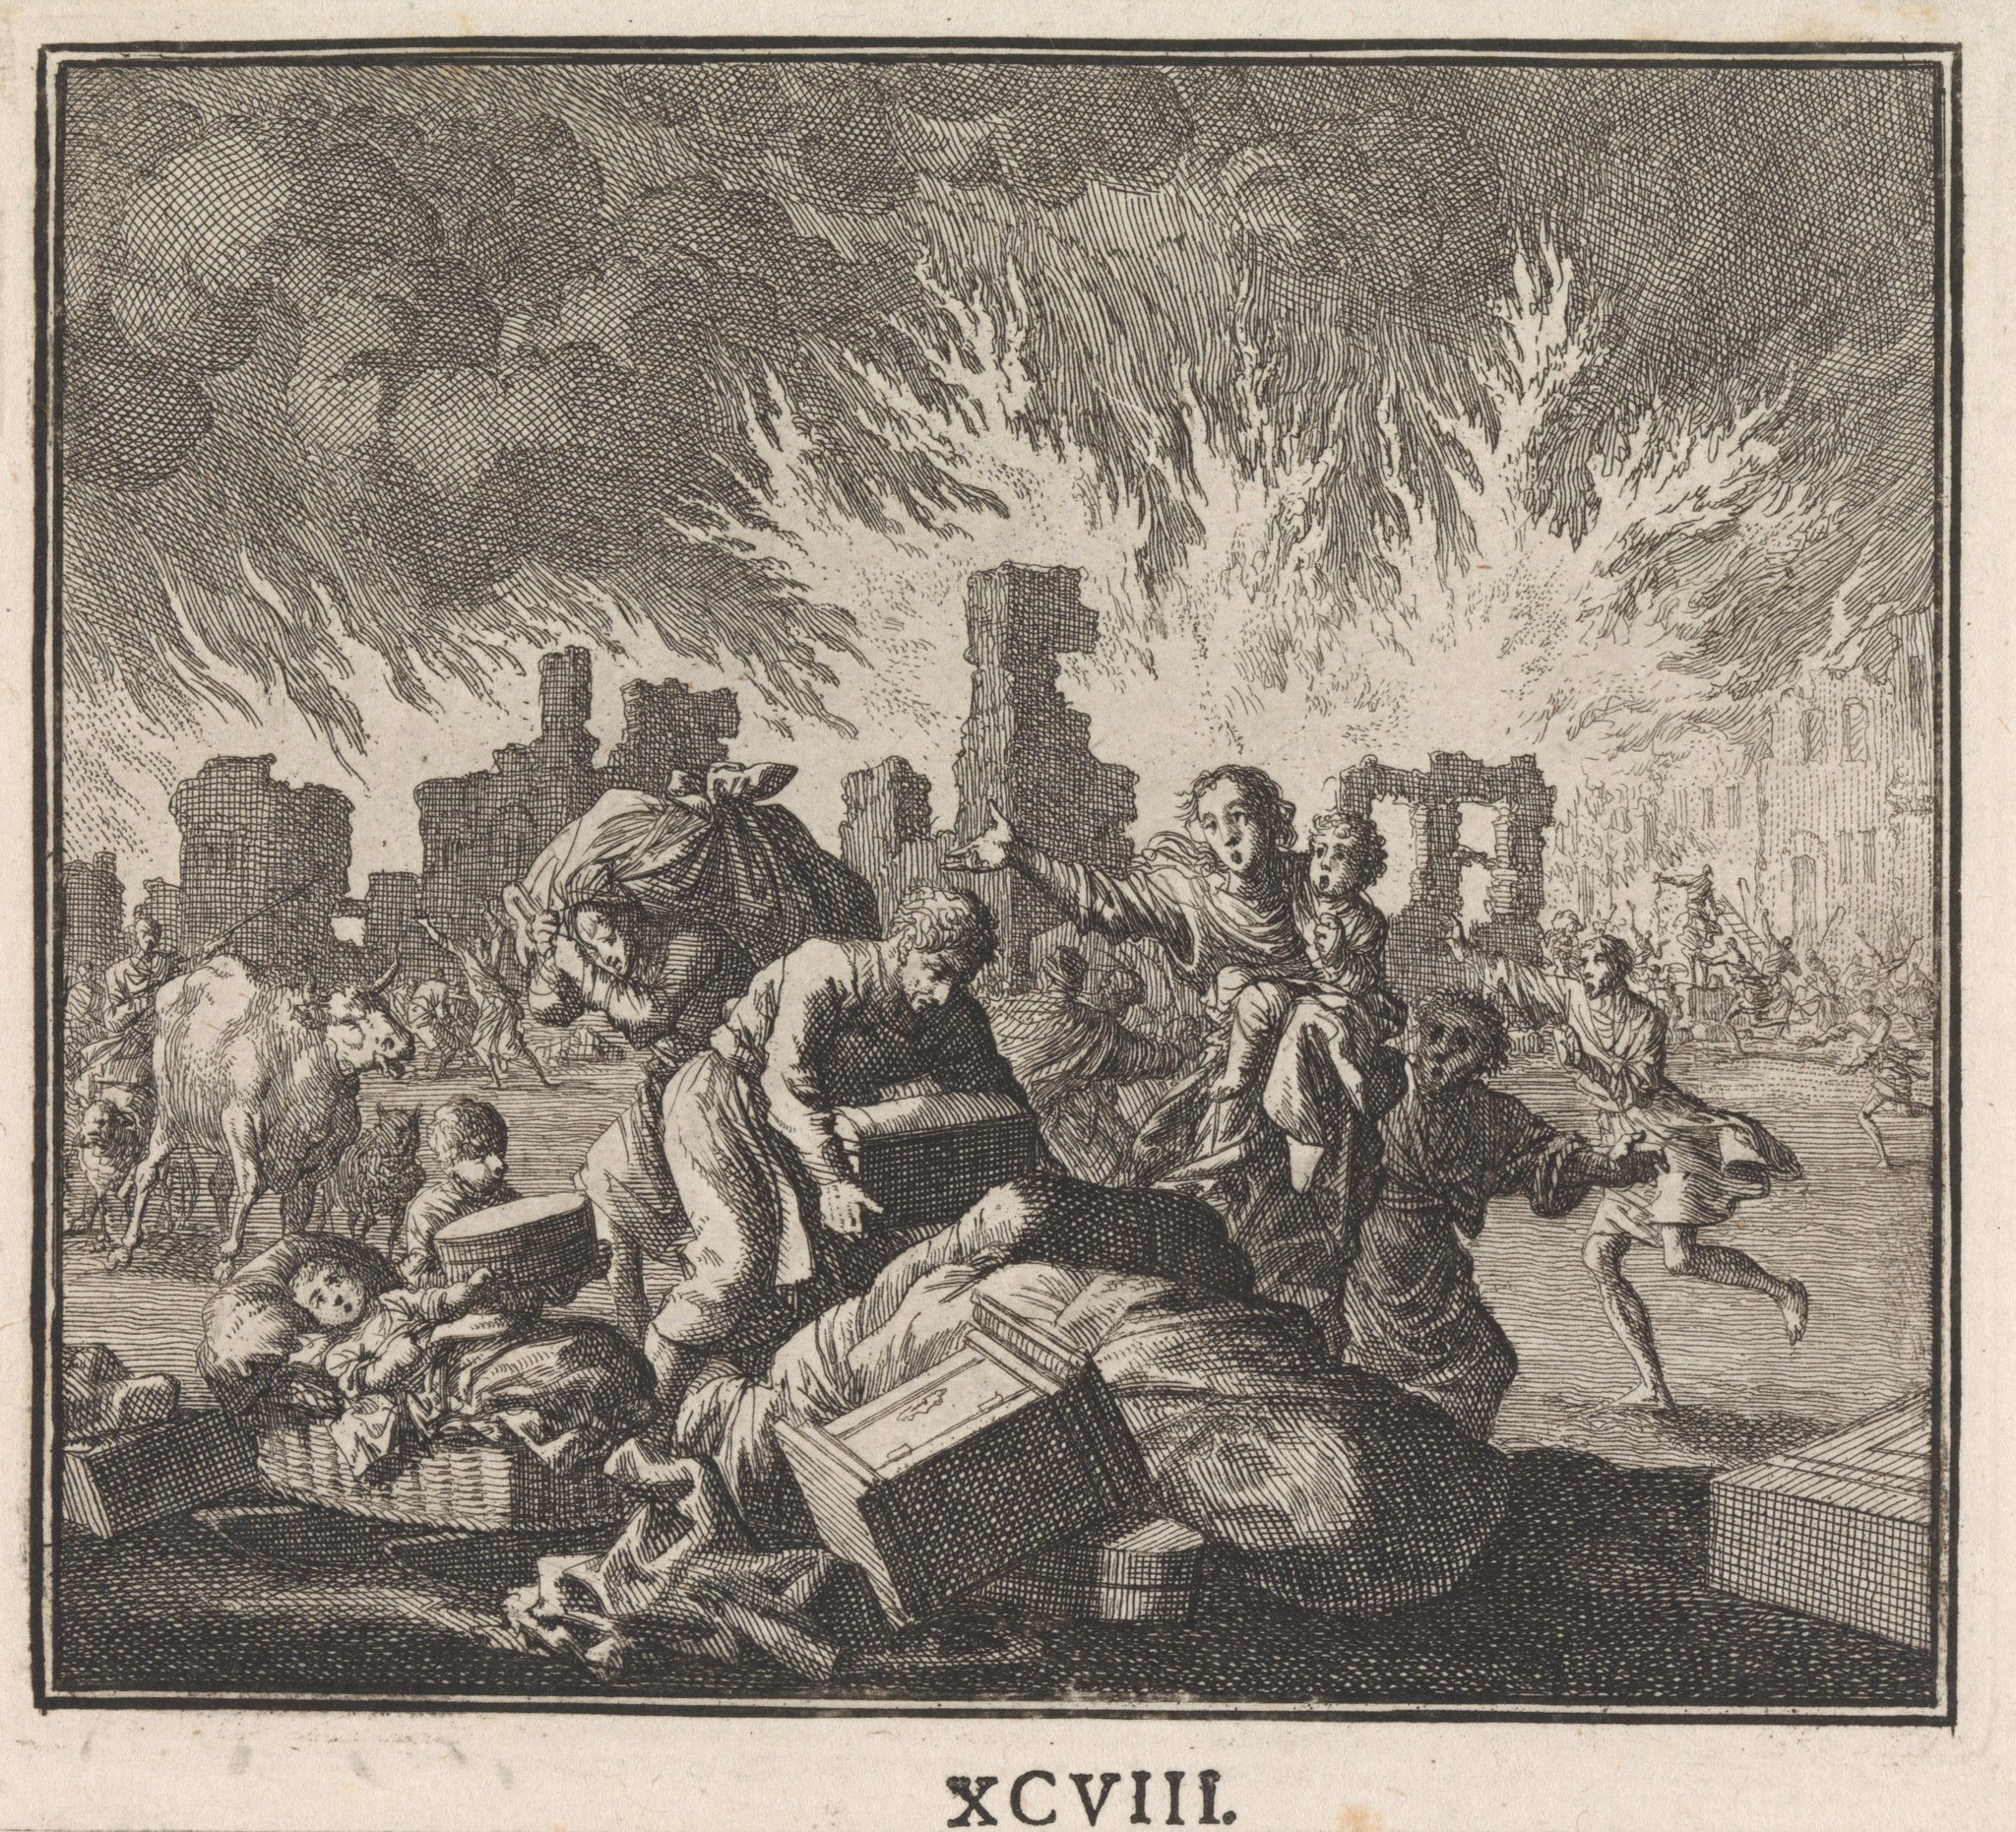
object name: book illustration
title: Embleem: vlammenzee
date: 1695-1705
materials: paper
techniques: etching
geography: nuremberg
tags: flight, running away; pursuing, setting on fire (of conquered city), abstract ideas and concepts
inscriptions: collector's mark: Lugt 2228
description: Boekillustratie voor Weigel, Christoph. Ethica Naturalis seu Documenta Moralia e Variis rerum Naturalium proprietatibus Virtutum Vitiorumq symbolicis imaginibus collecta. Neurenberg: Christoph Weigel: c. 1700.